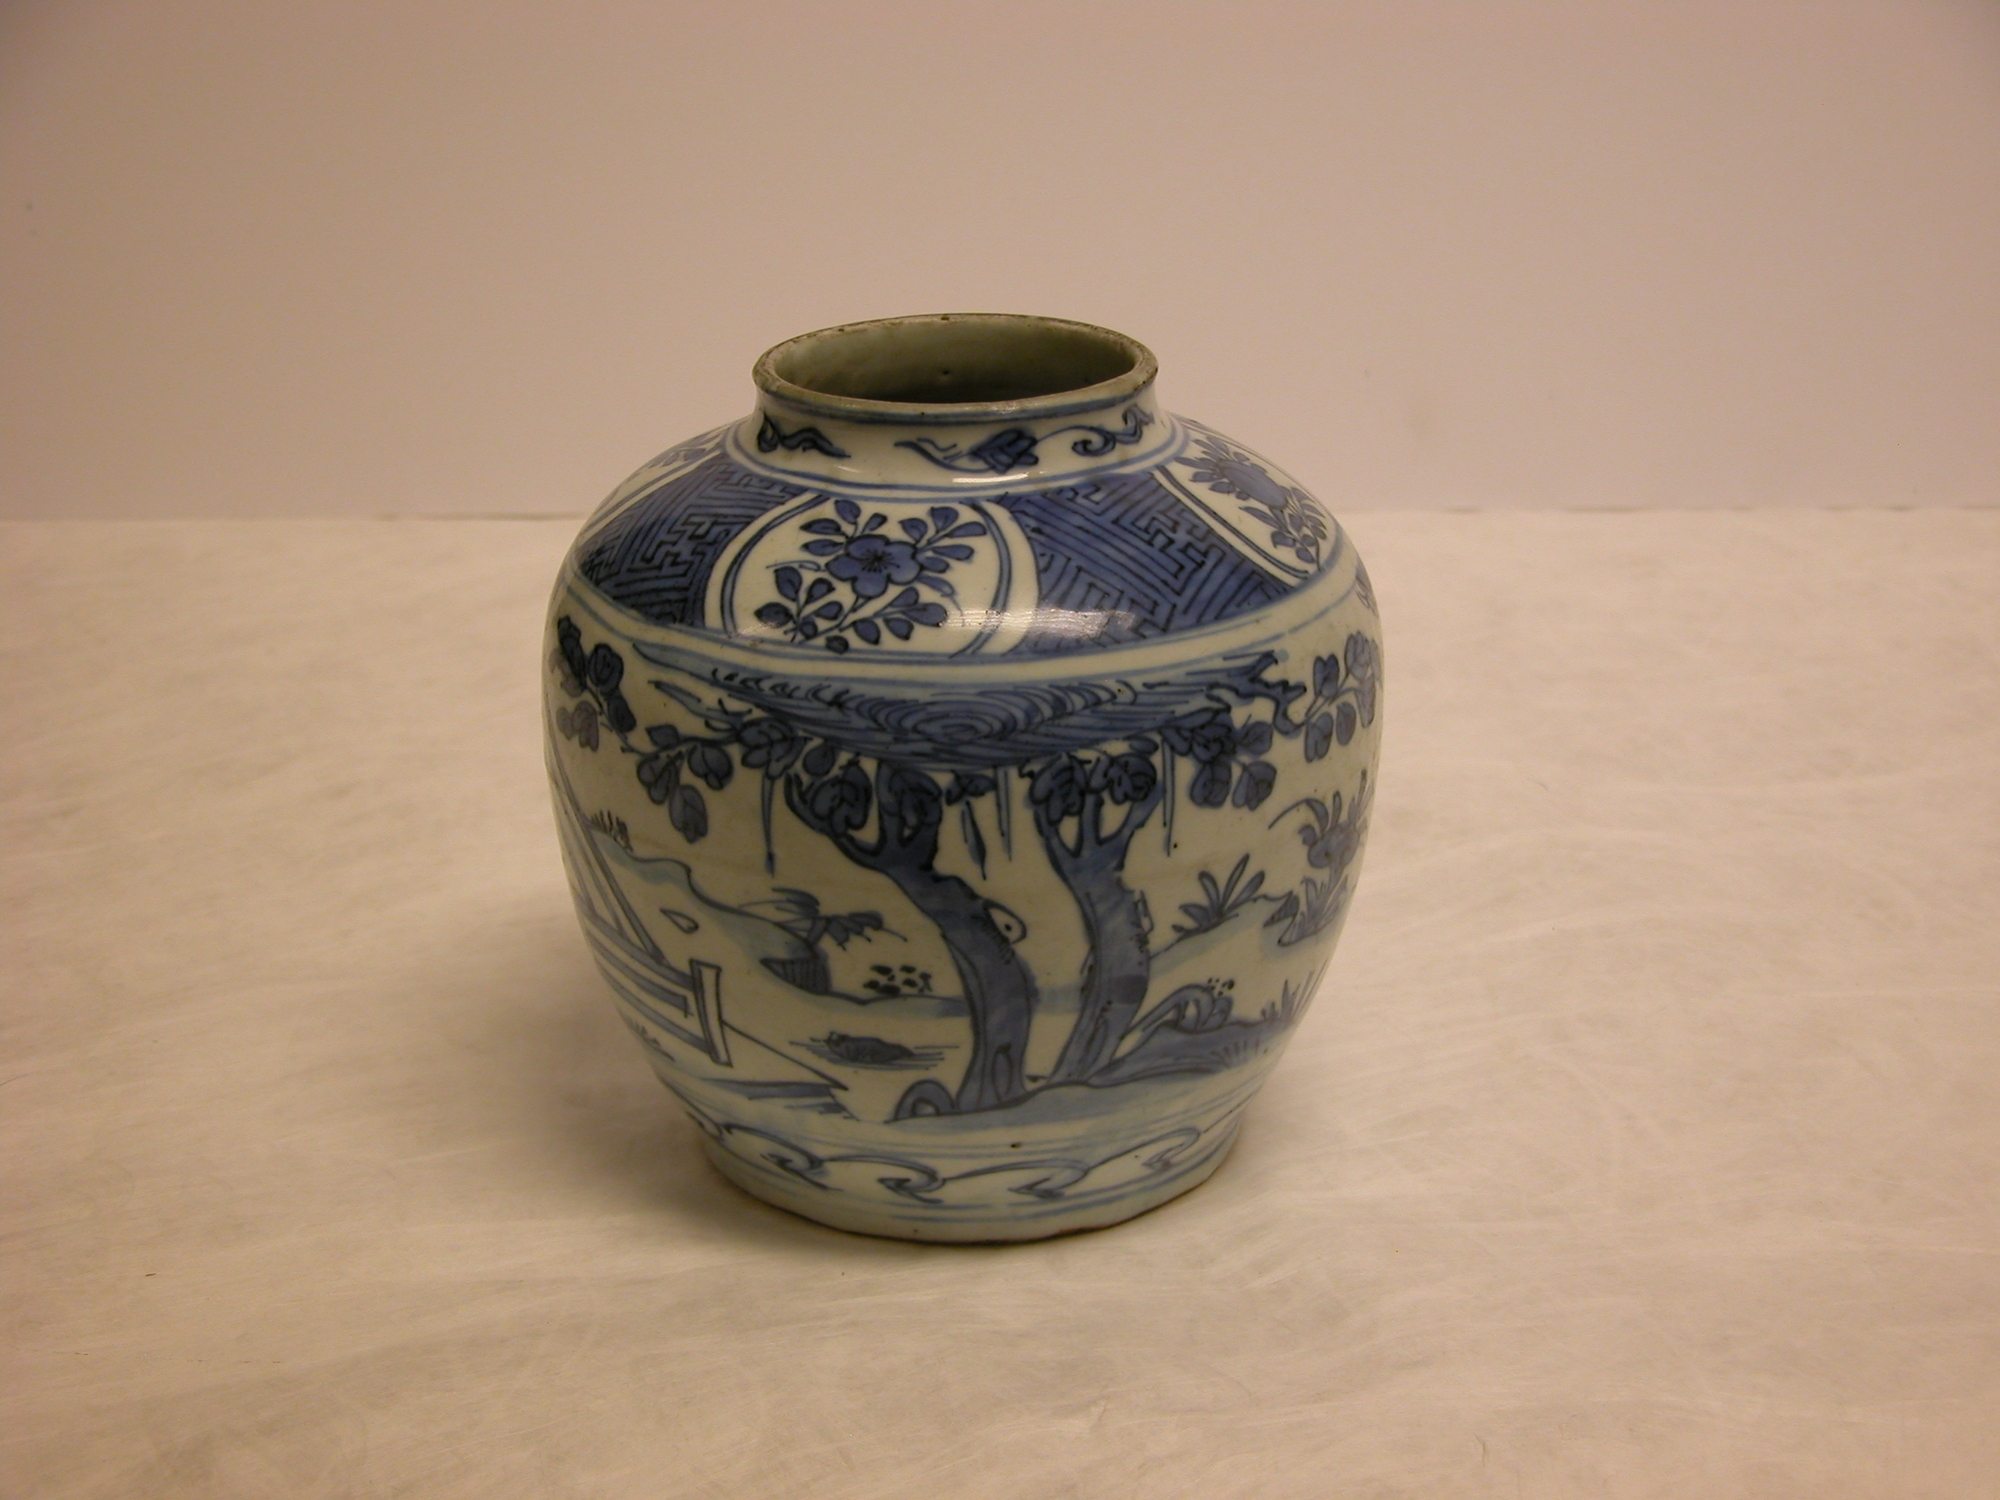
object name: jar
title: Jar with scene of Wang Xizhi (303–361) watching geese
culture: chinese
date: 1567-1600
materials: cobalt, glaze, porcelain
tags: flowers,leaves,trees